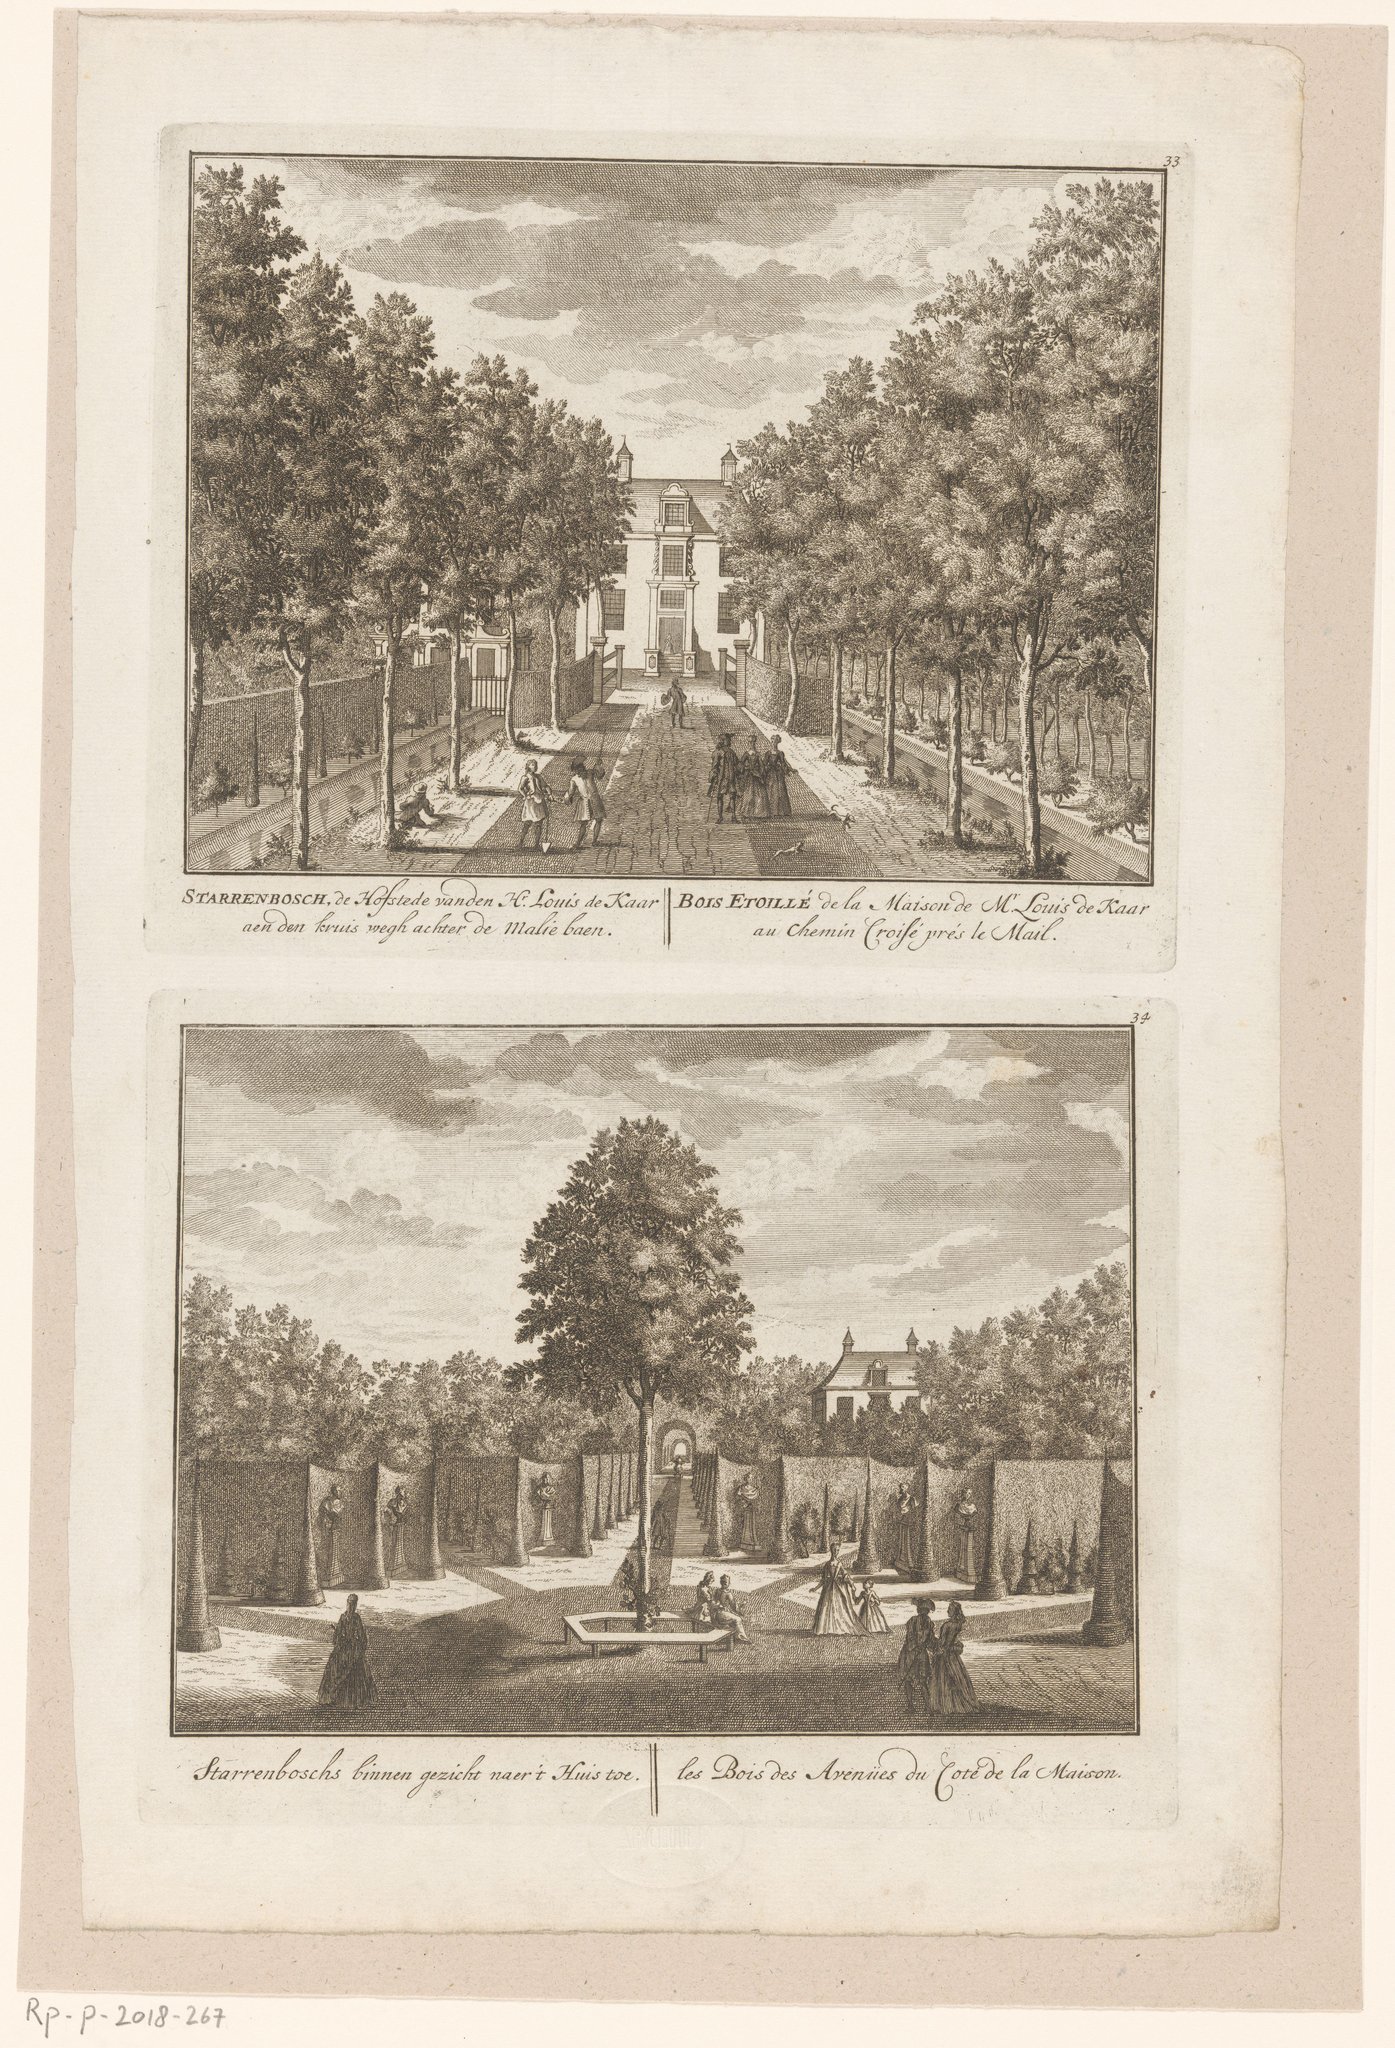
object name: print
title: Starrenboschs binnen gezicht naer 't huis toe / Les Bois des Avenües du coté de la maison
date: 1725-1768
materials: paper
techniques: engraving, etching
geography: amsterdam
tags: french or architectonic garden; formal garden, country-house, amsterdam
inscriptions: check stamp: ‘Archief Ministerie van Oorlog Afdeeling Genie’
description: Prent gebruikt in: Niedek, Mattaeus Brouërius. Het verheerlykt Watergraafs- of Diemermeer by de stadt Amsterdam (...). Amsterdam: Andries en Hendrik de Leth, 1725. Of in: Niedek, Mattaeus Brouërius. Het verheerlykt Watergraafs- of Diemermeer by de stadt Amsterdam (...). Amsterdam: Pieter Jan Entrop, 1768.